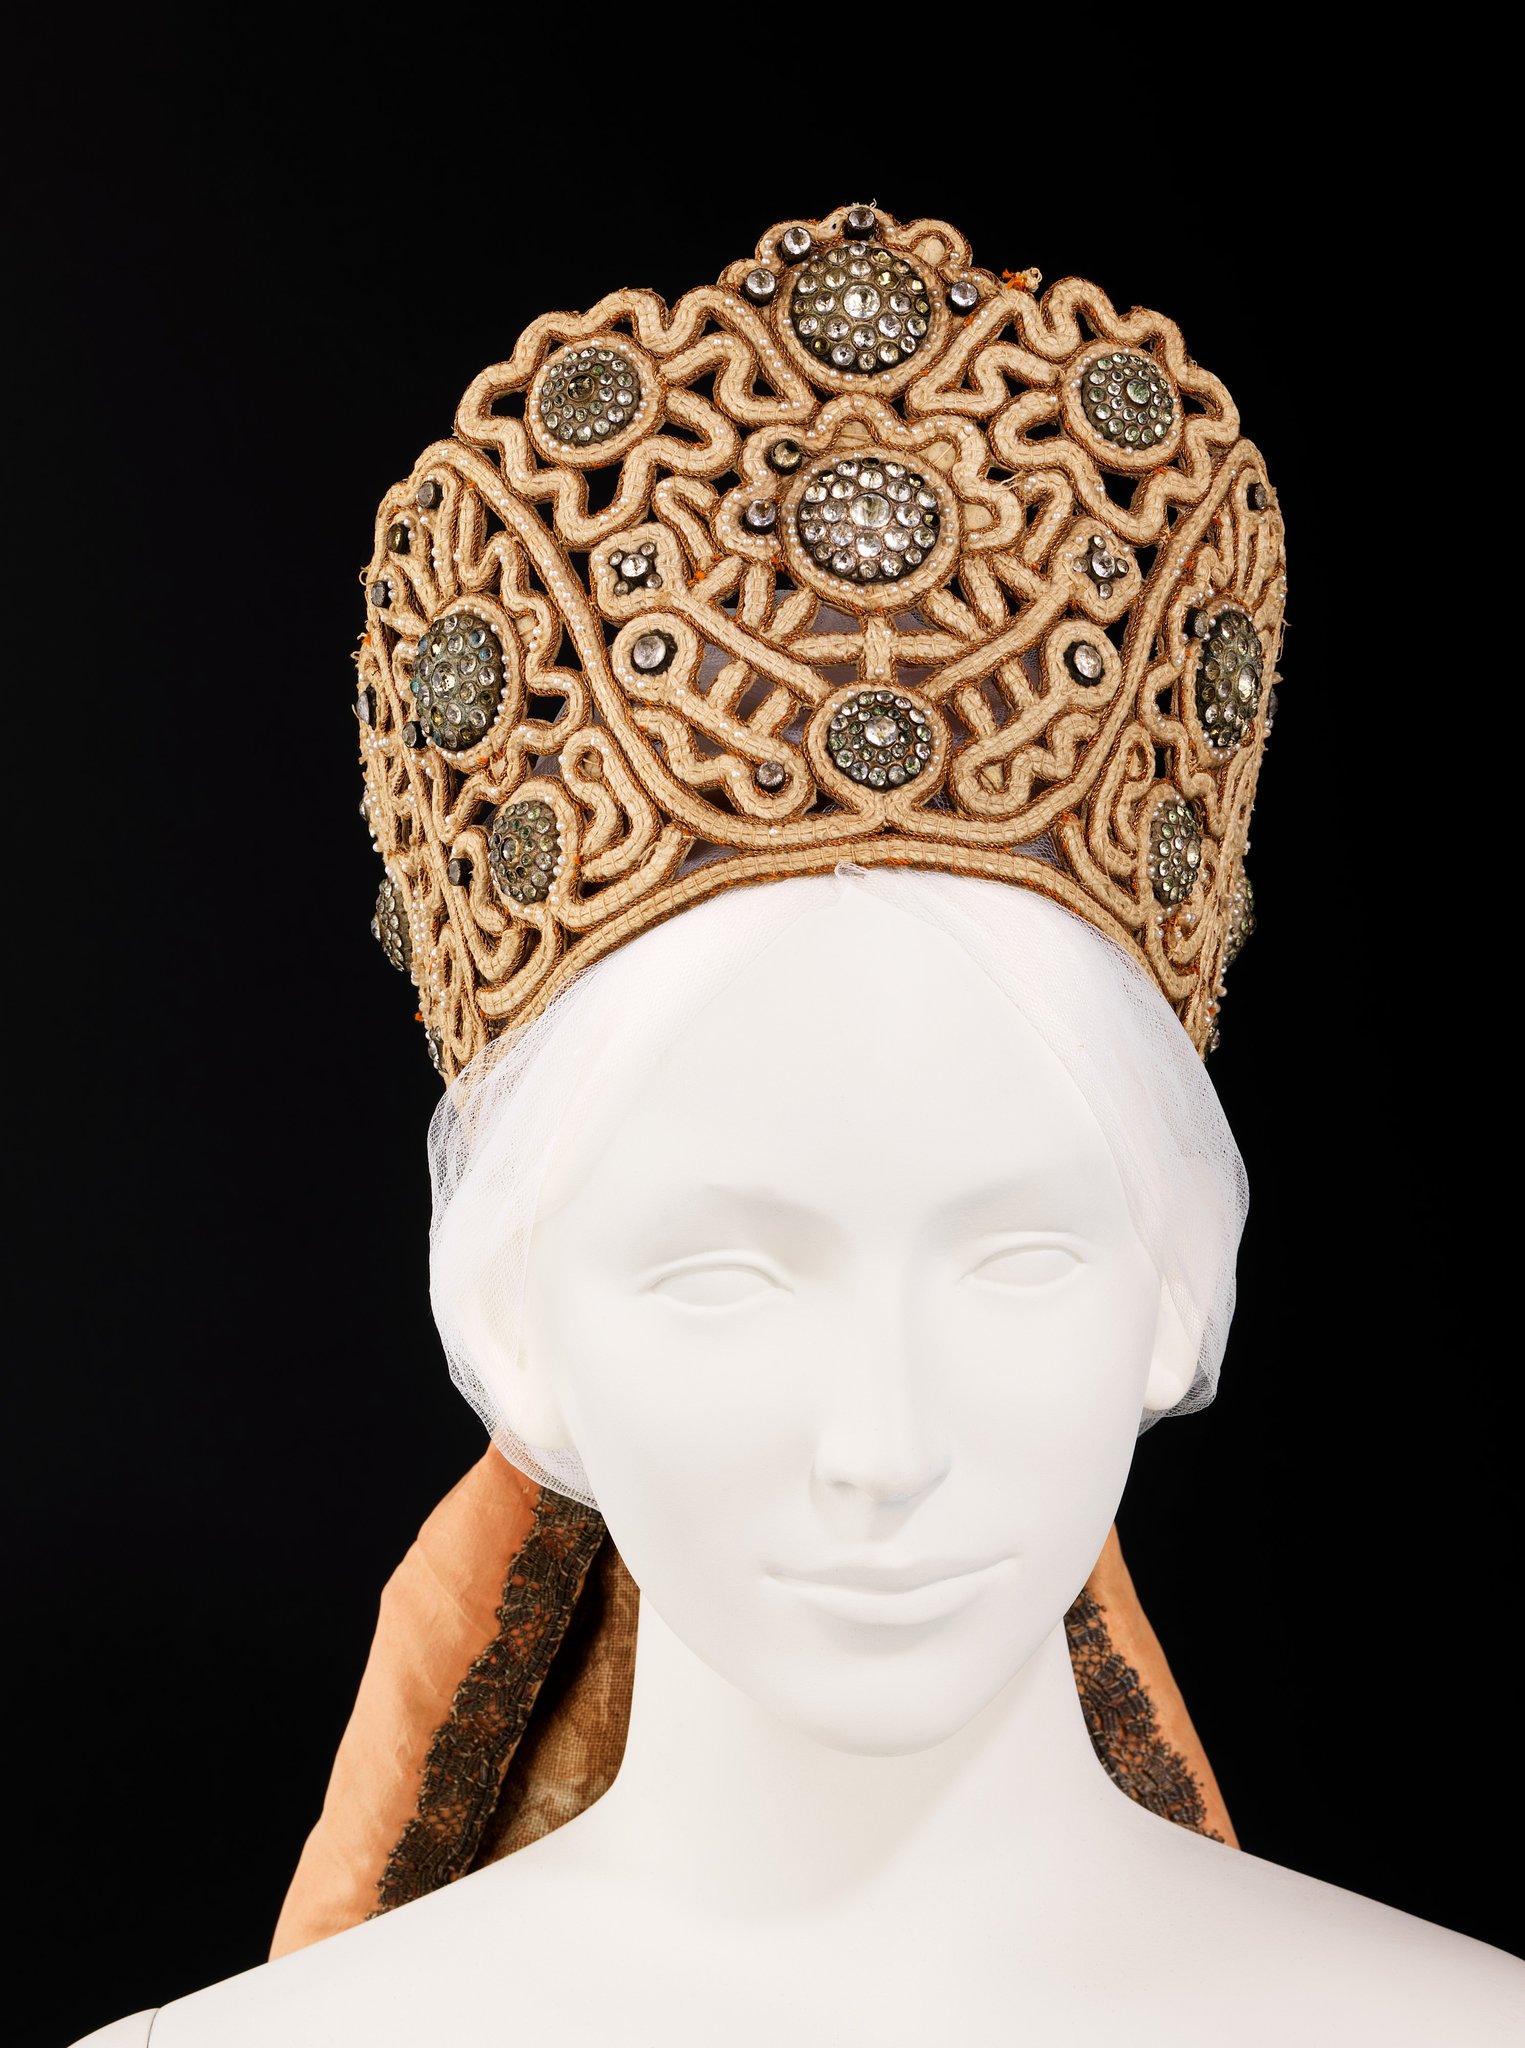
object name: headdress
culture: russian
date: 1795-1805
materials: cotton, glass, metal, paper, pearl, silk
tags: diadems